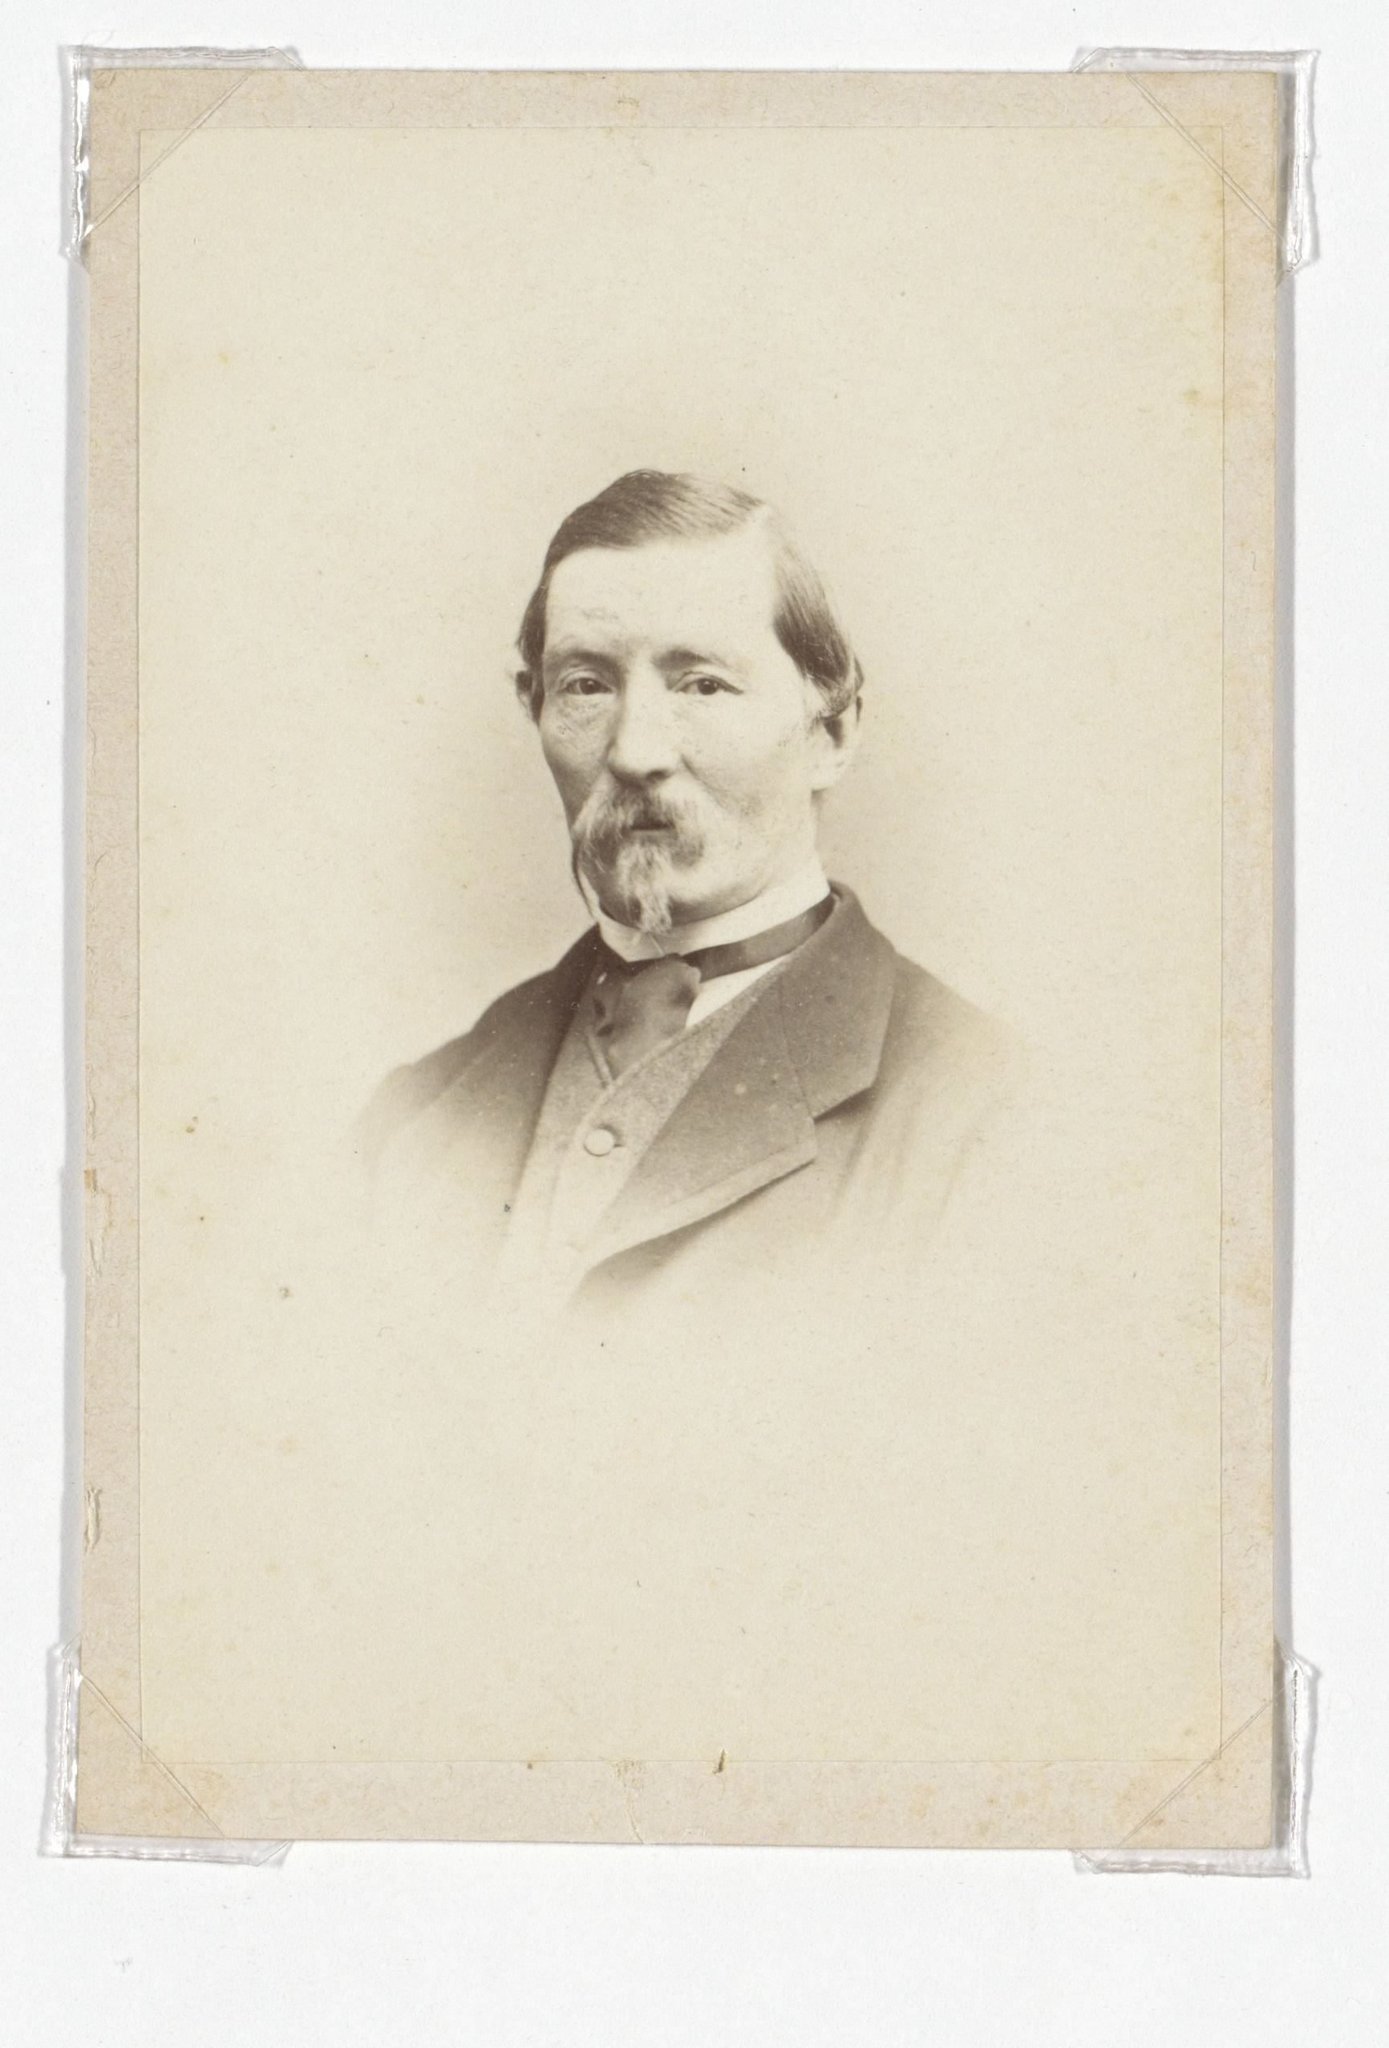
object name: carte de visite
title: Portret van een man met een snor en een sik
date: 1868-1880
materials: cardboard, paper, photographic support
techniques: albumen print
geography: netherlands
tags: historical persons not known by name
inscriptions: address: ‘Kalverstraat over den Heyligenweg D.26. Amsterdam. / Leidsche Straatweg Buiten Cathrijnen Utrecht.’